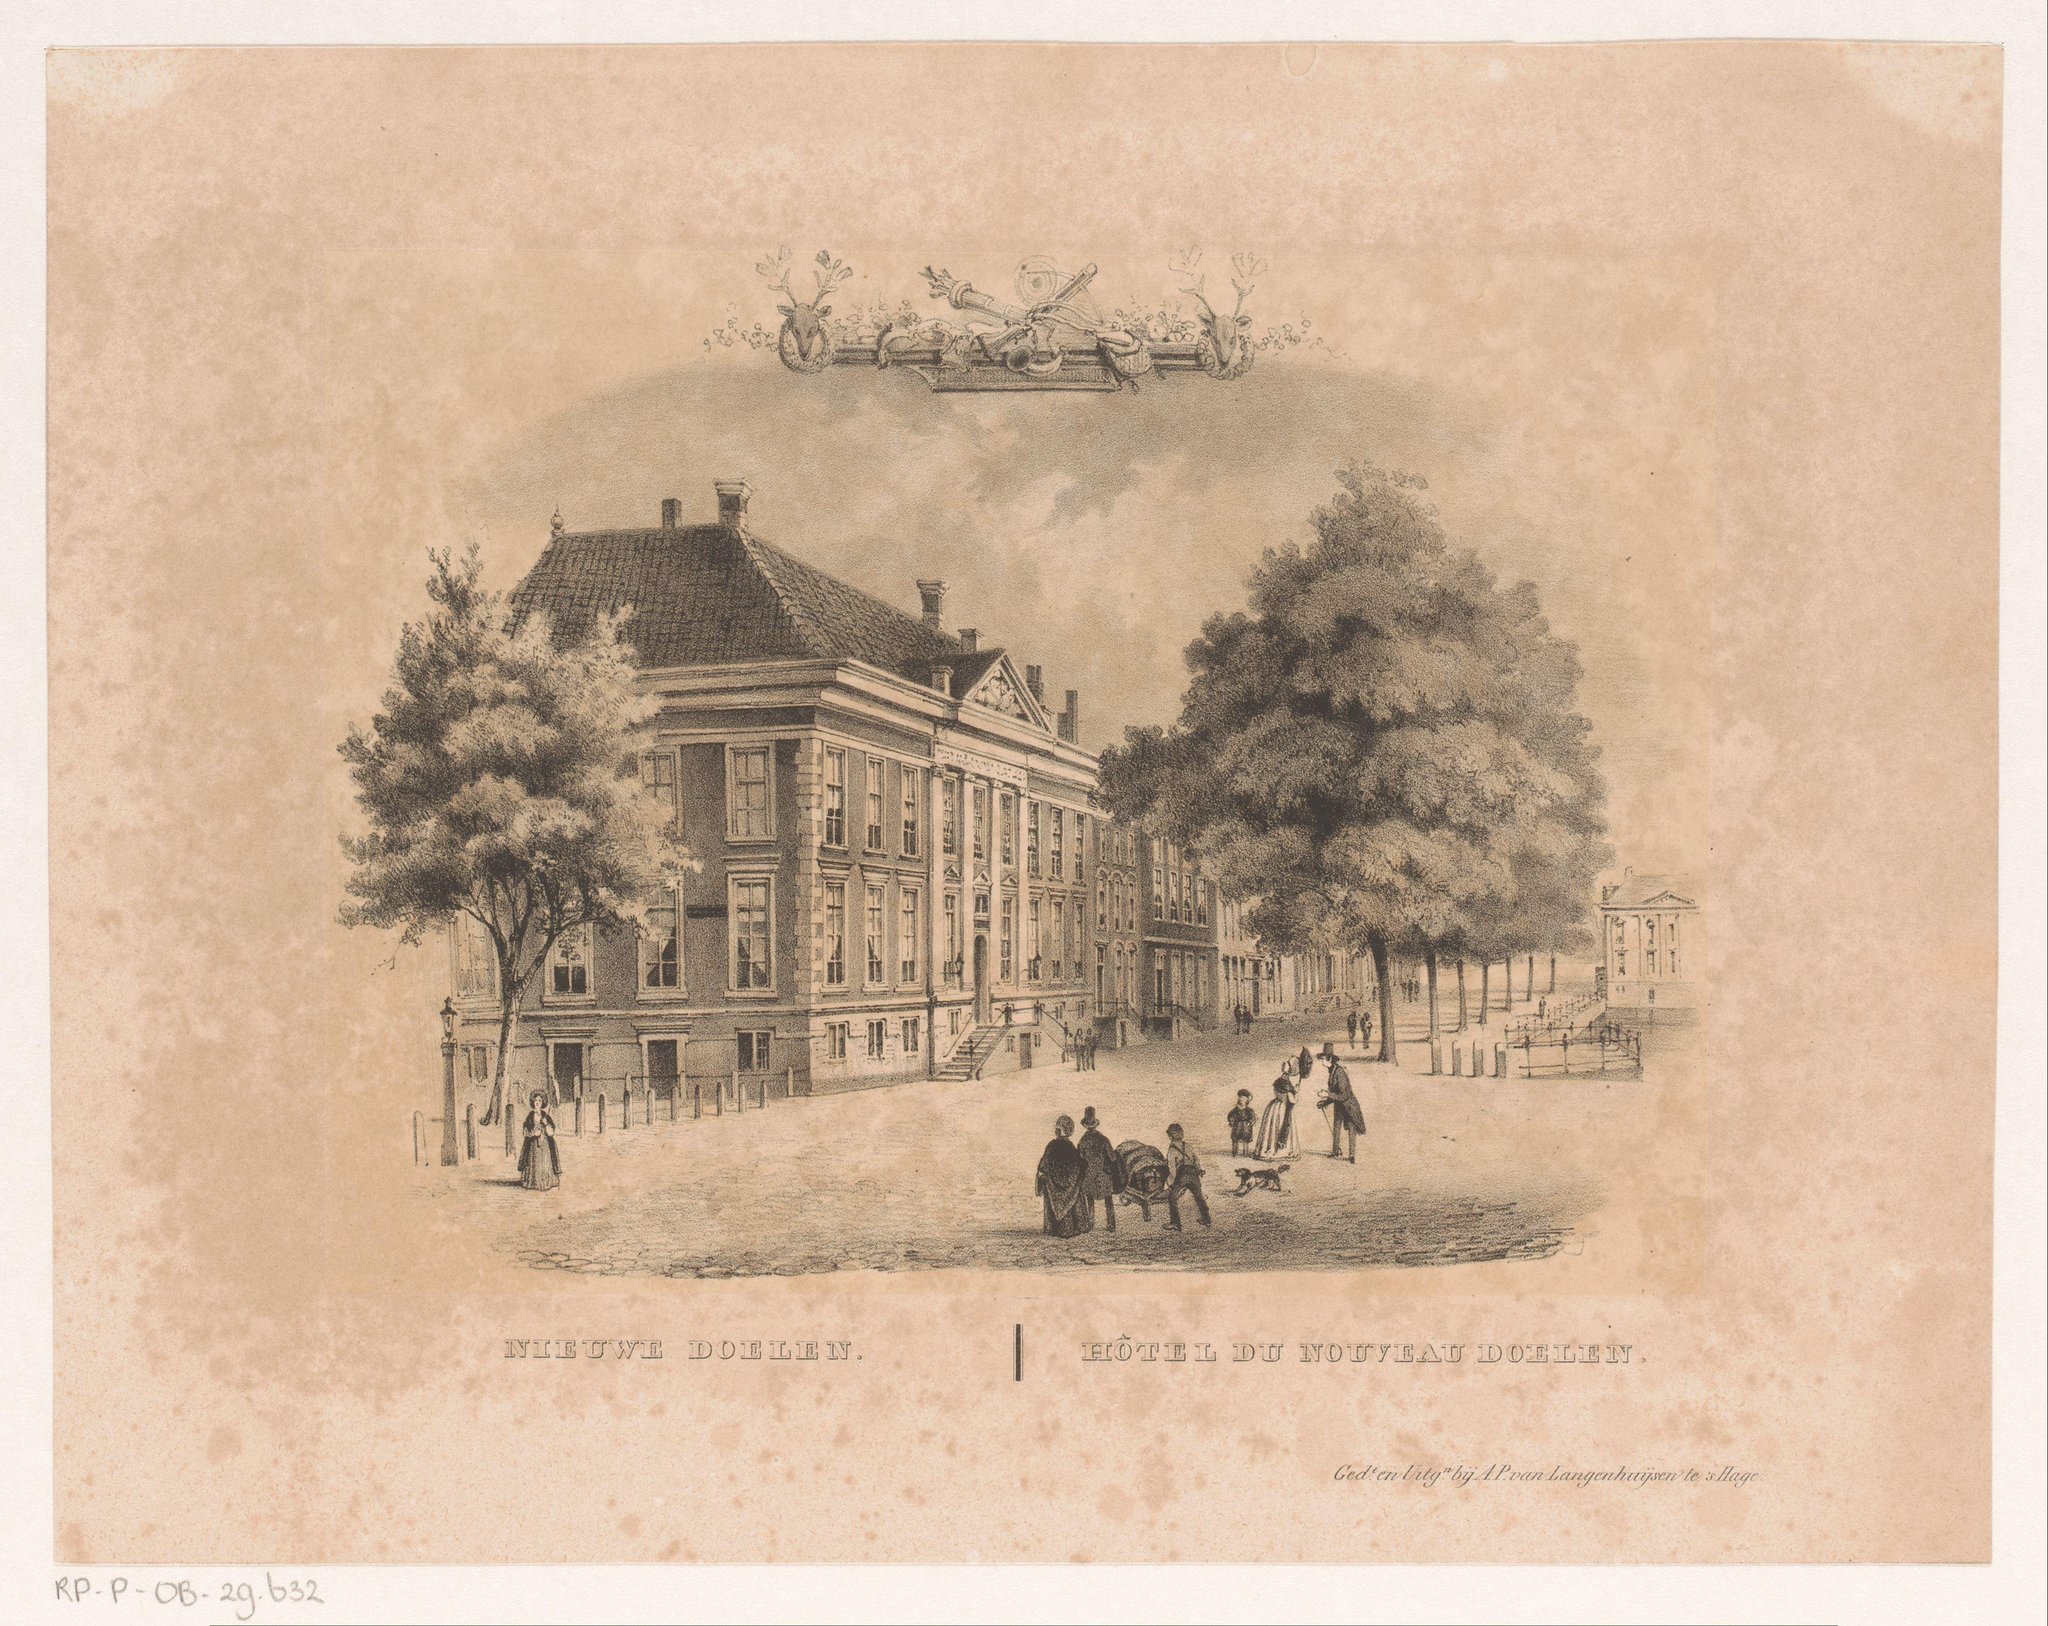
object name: print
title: Sint Sebastiaansdoelen te Den Haag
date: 1830-1846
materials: paper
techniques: tone lithography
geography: the hague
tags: façade (of house or building), the hague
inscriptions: collector's mark: Lugt 2228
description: Mensen op straat voor de Sint Sebastiaansdoelen. Tegenwoordig bevindt zich hier het Haags Historisch Museum.